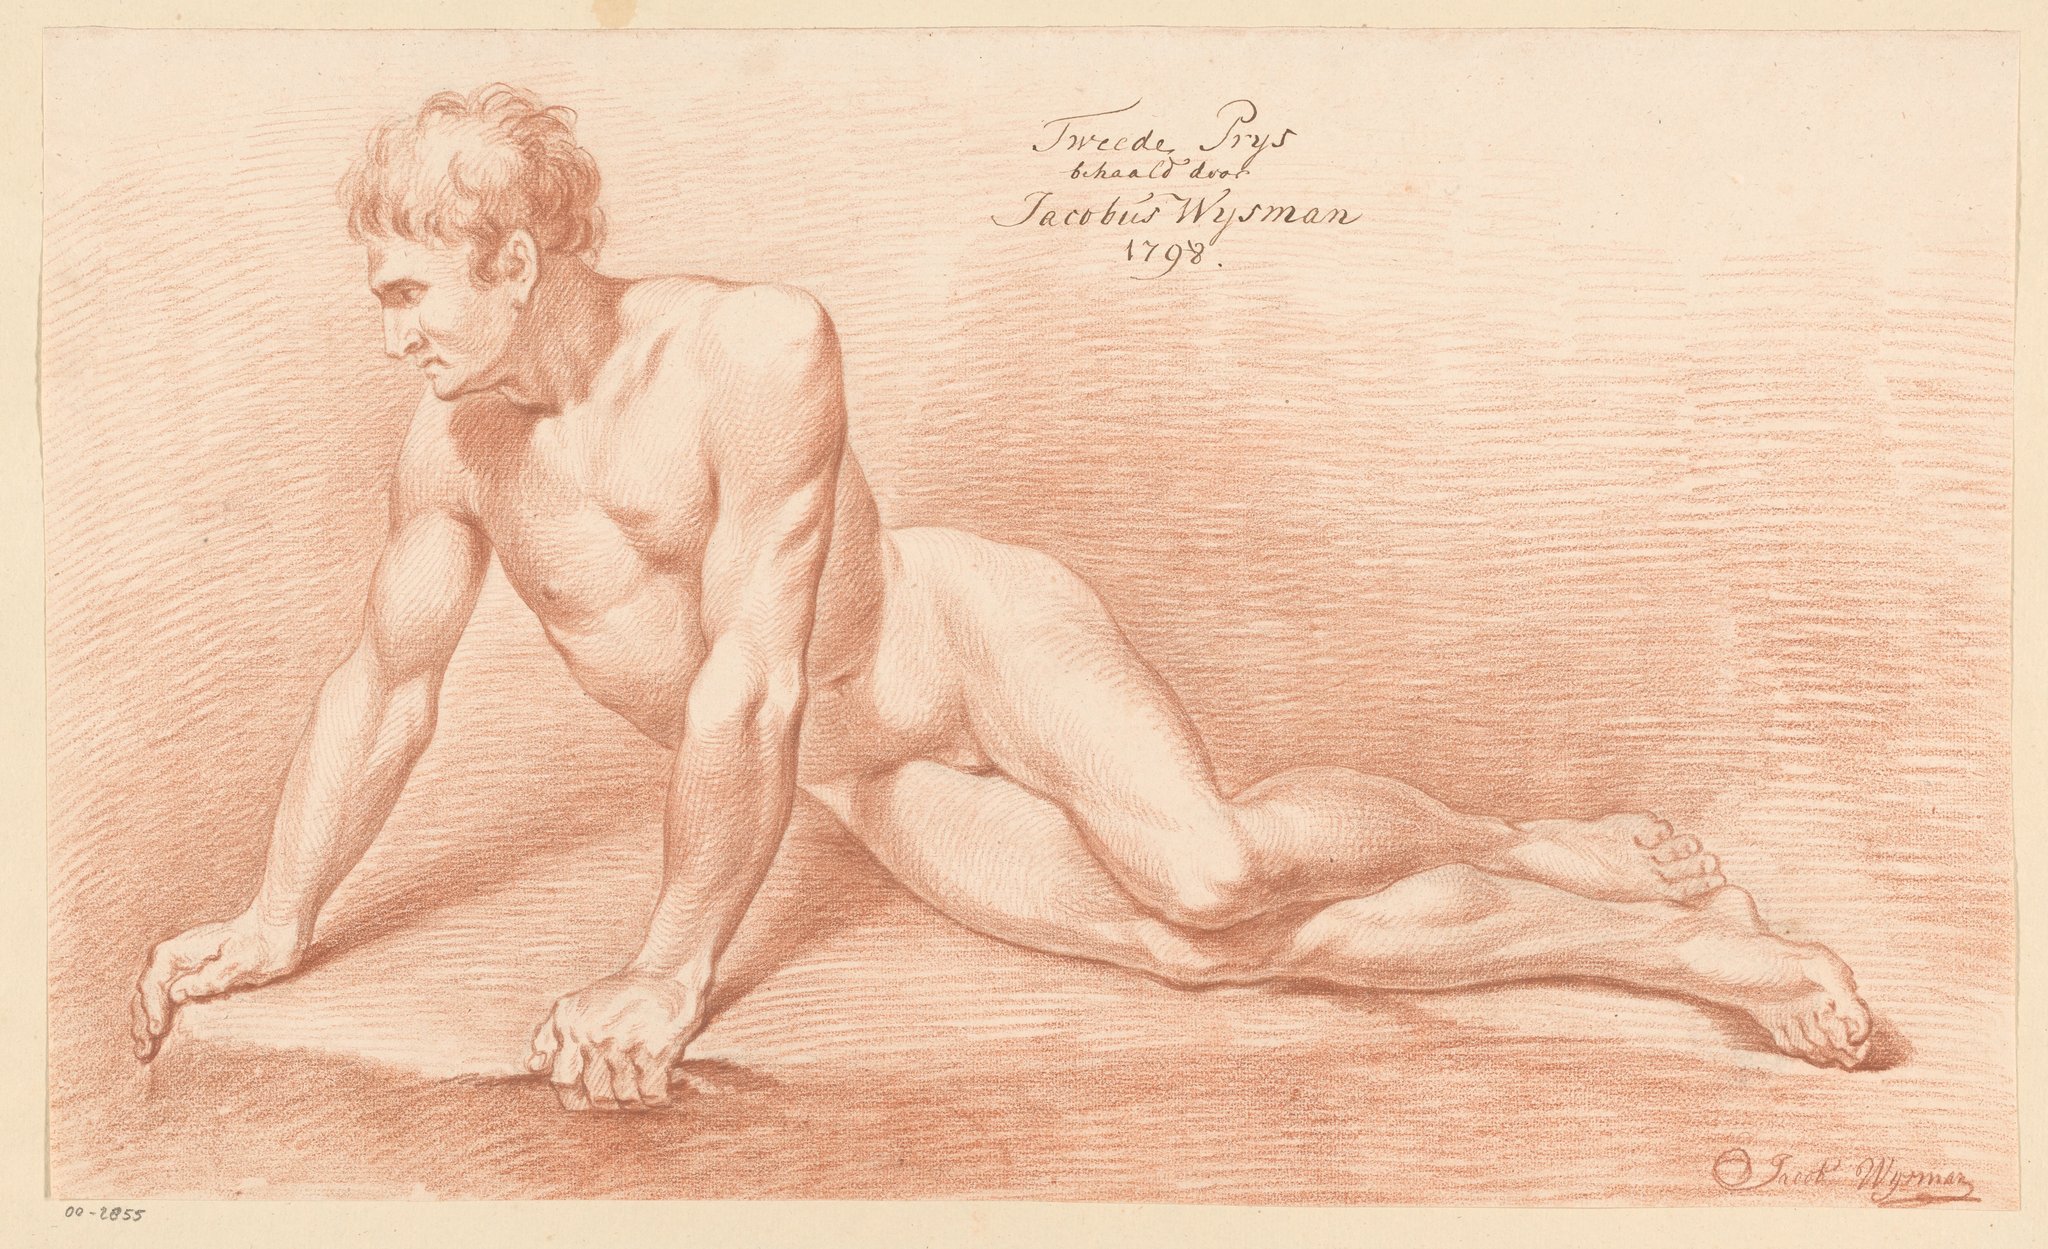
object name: drawing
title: Zittend mannelijk naakt, van voren gezien (2e prijs 1798)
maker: jacobus wijsman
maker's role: print maker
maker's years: 1768-1827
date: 1798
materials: chalk, charcoal, paper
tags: sitting figure (+ nude human being)